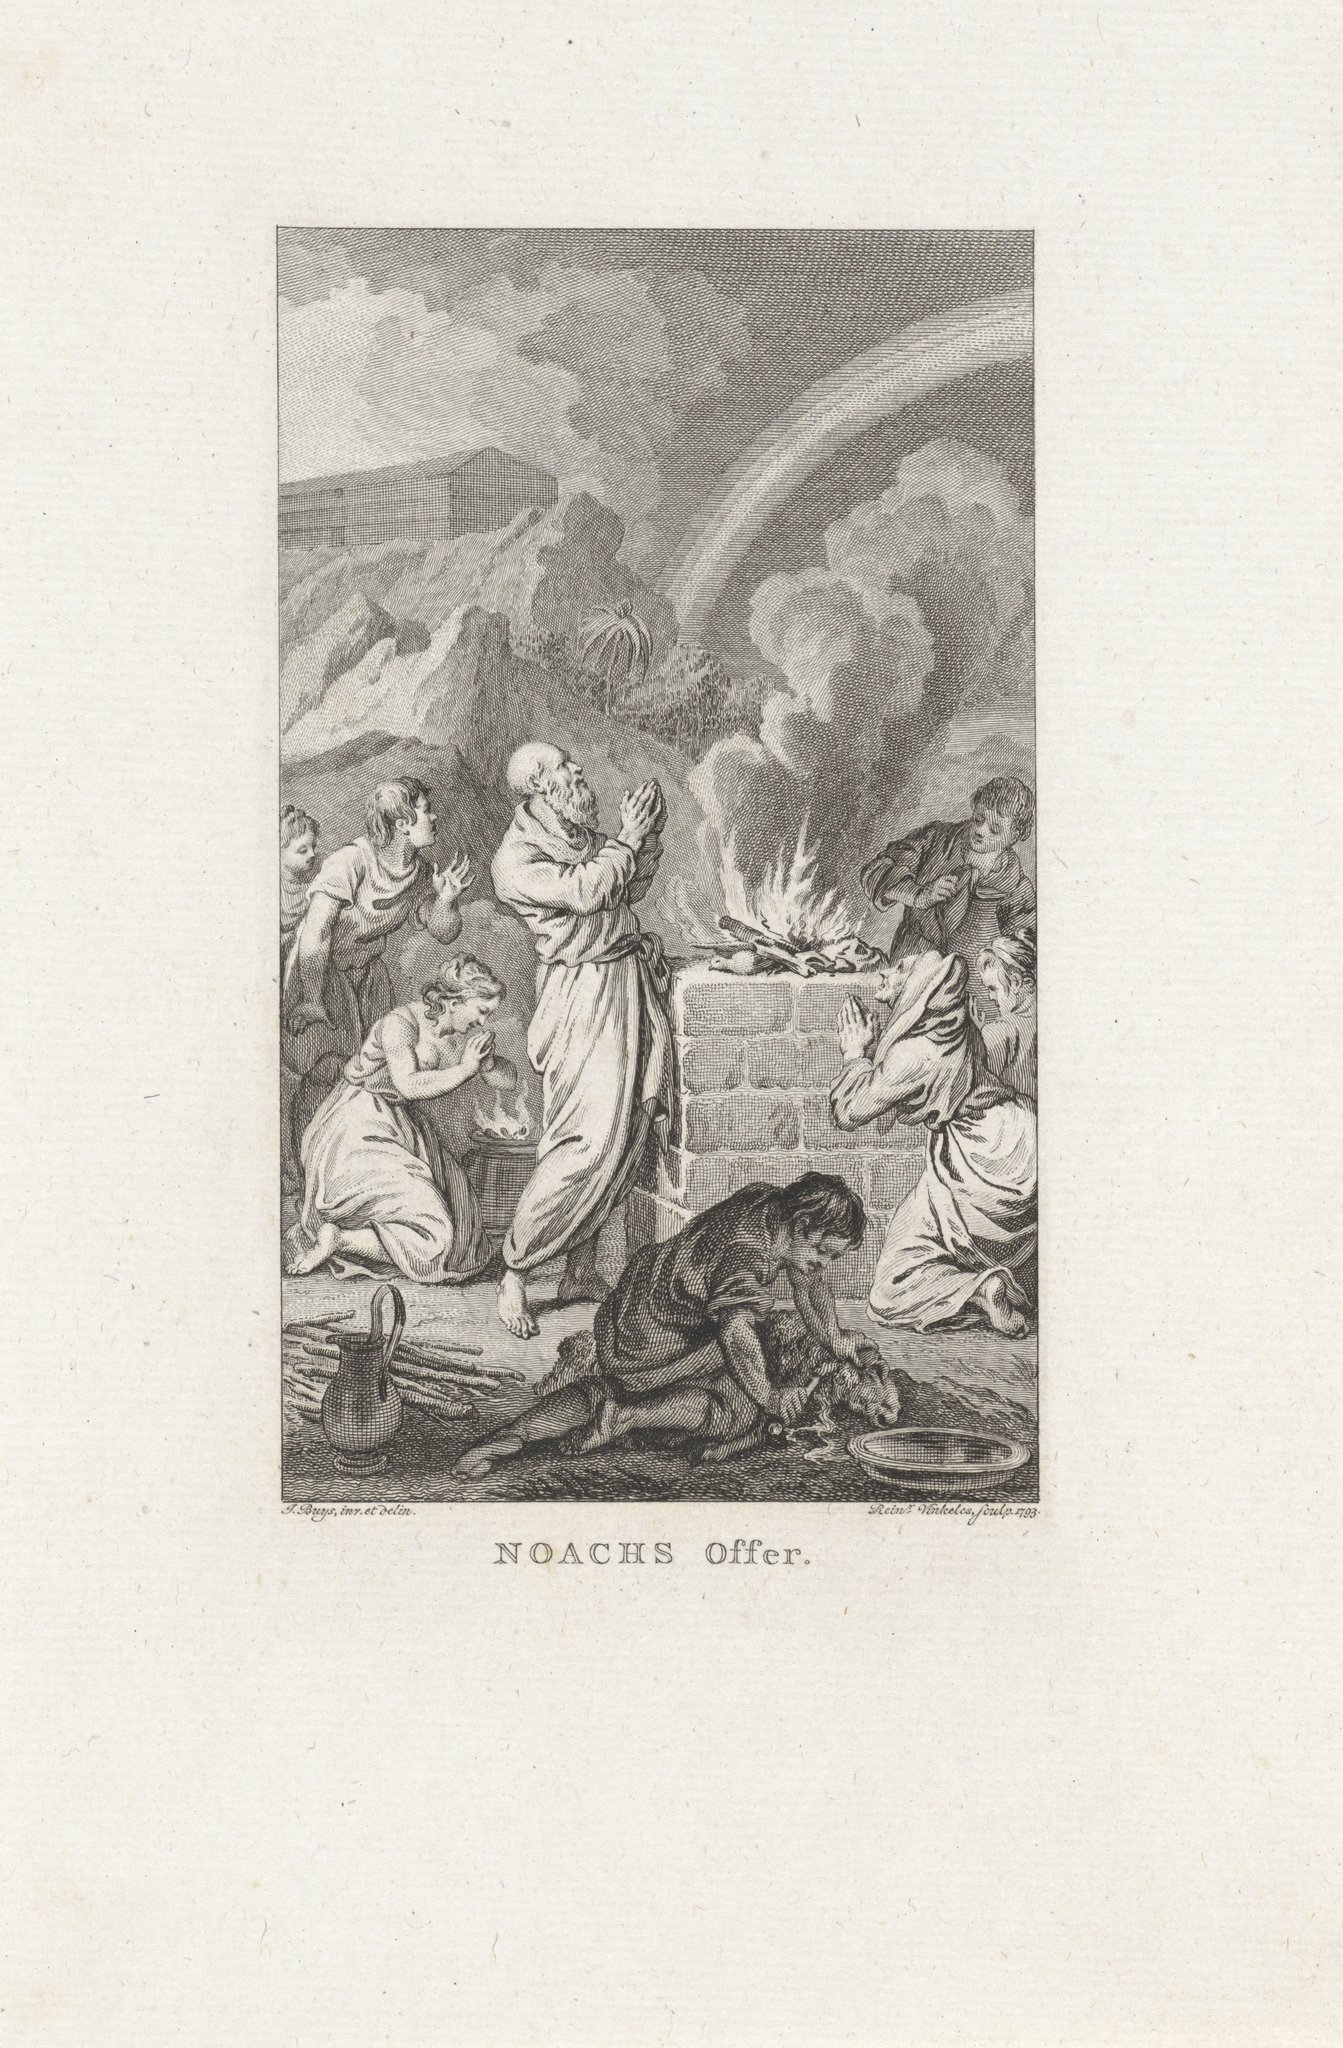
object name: print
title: Noachs offer.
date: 1793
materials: paper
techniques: engraving, etching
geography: amsterdam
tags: noah's sacrifice; various animals are offered, possibly a lamb, a dove and a ram (often combined with the rainbow of the covenant)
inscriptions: collector's mark: Lugt 240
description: Noach en zijn gezin bidden bij het altaar, waar zij een lam offeren. Vol ontzag kijken ze naar de hemel waar een regenboog verschijnt, als teken van het verbond.